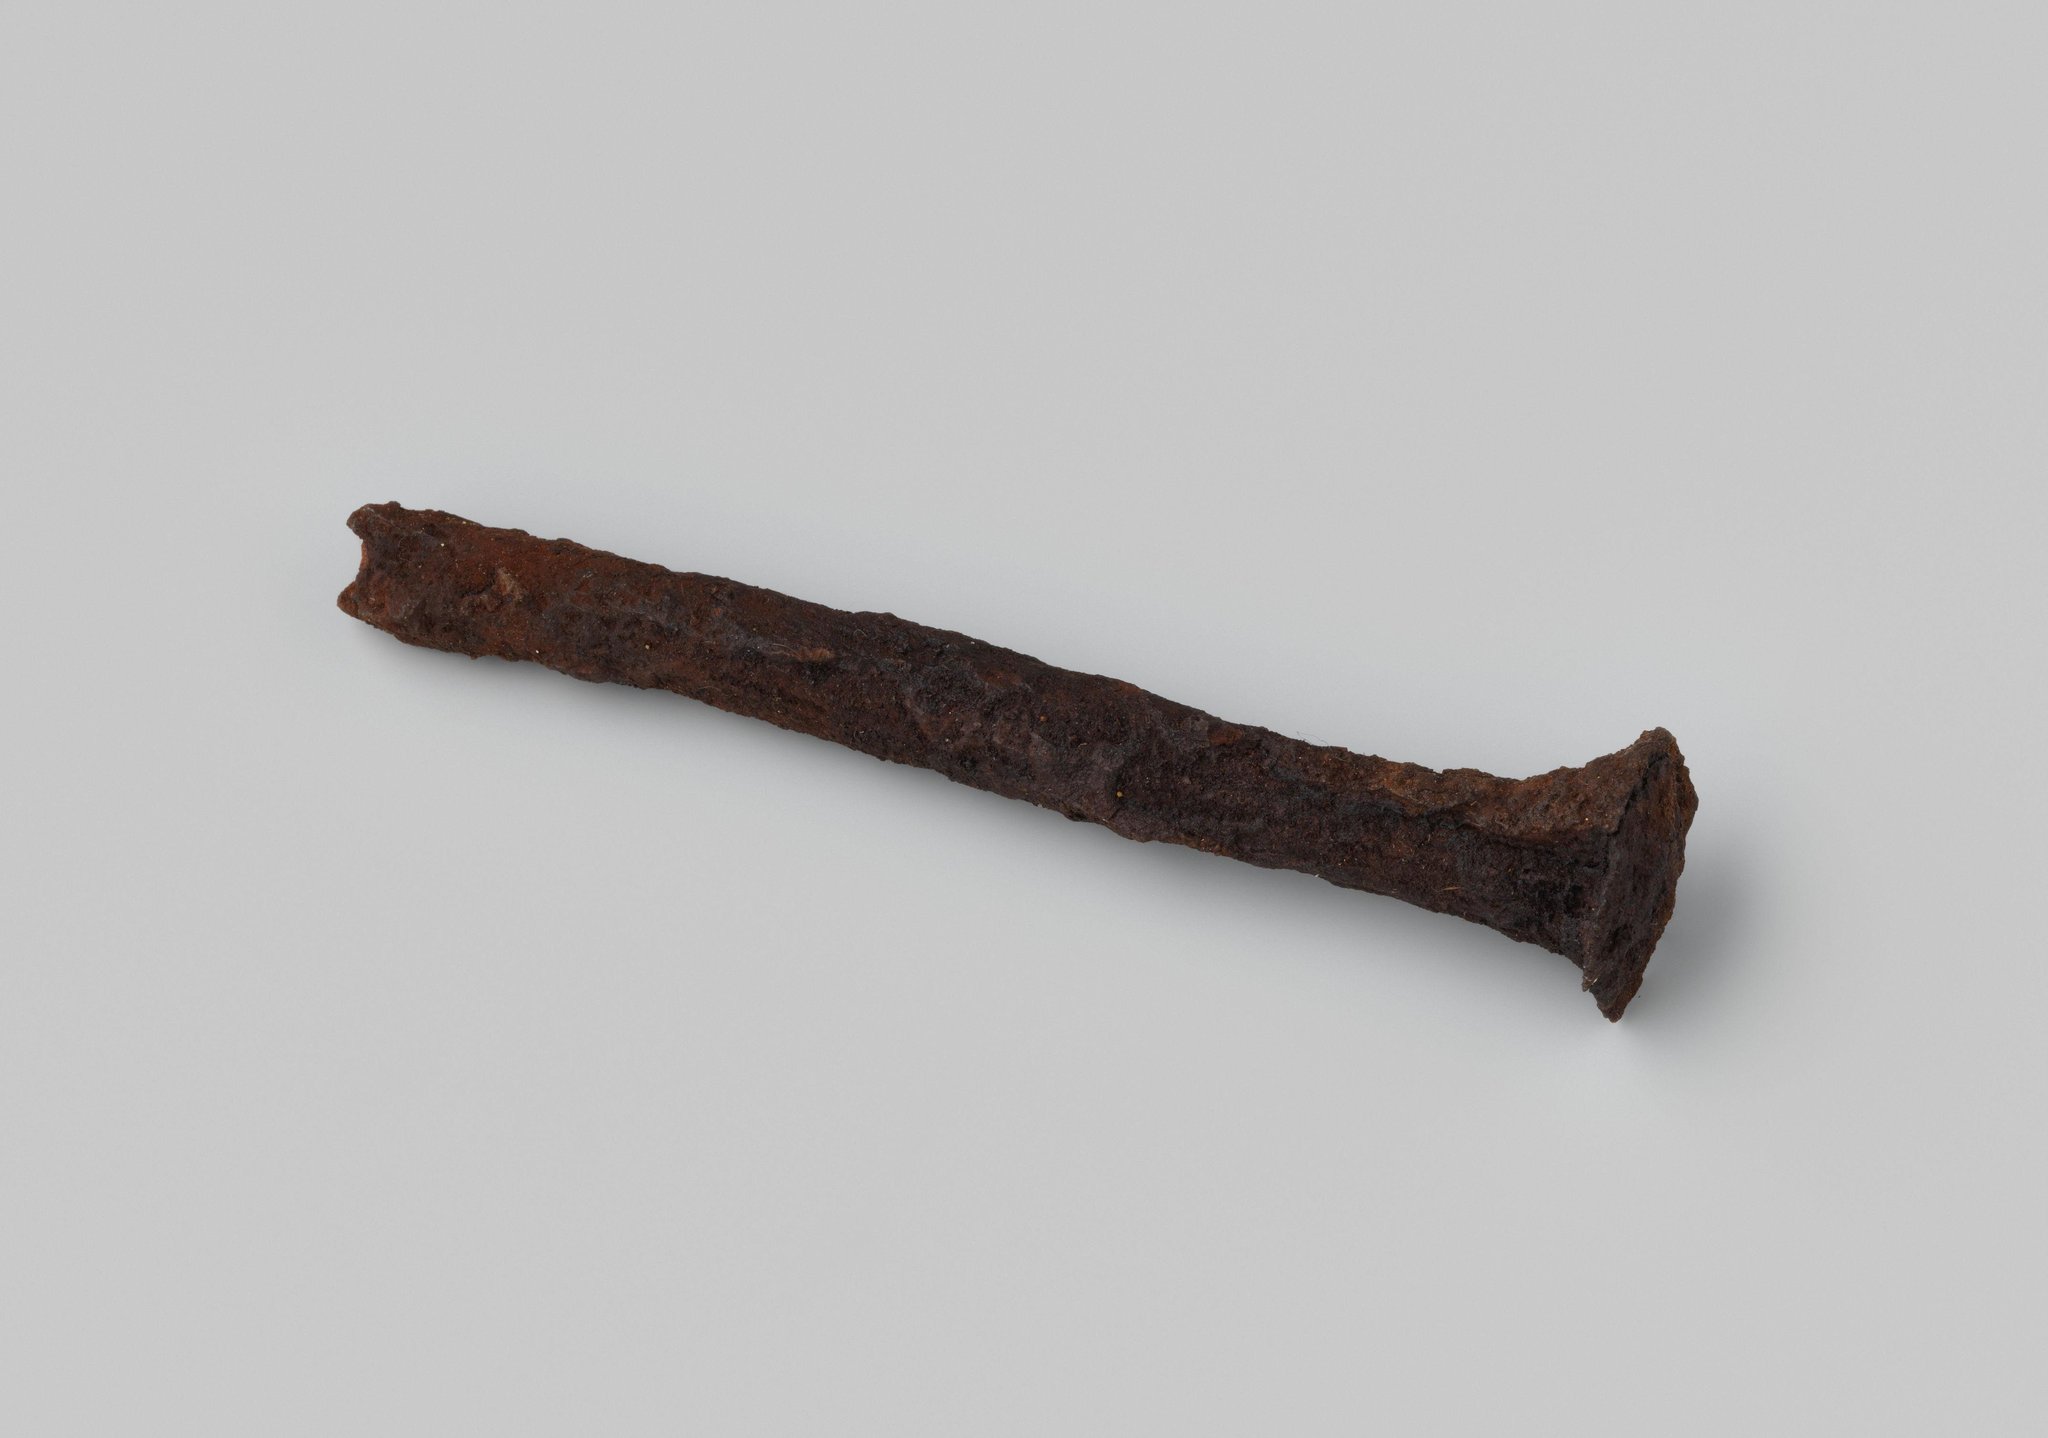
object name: bolt tongs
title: Bout afkomstig uit het wrak van de Oost-Indiëvaarder Hollandia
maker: Anonymous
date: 1700-1743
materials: iron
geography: netherlands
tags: verenigde oostindische compagnie, hollandia (schip)